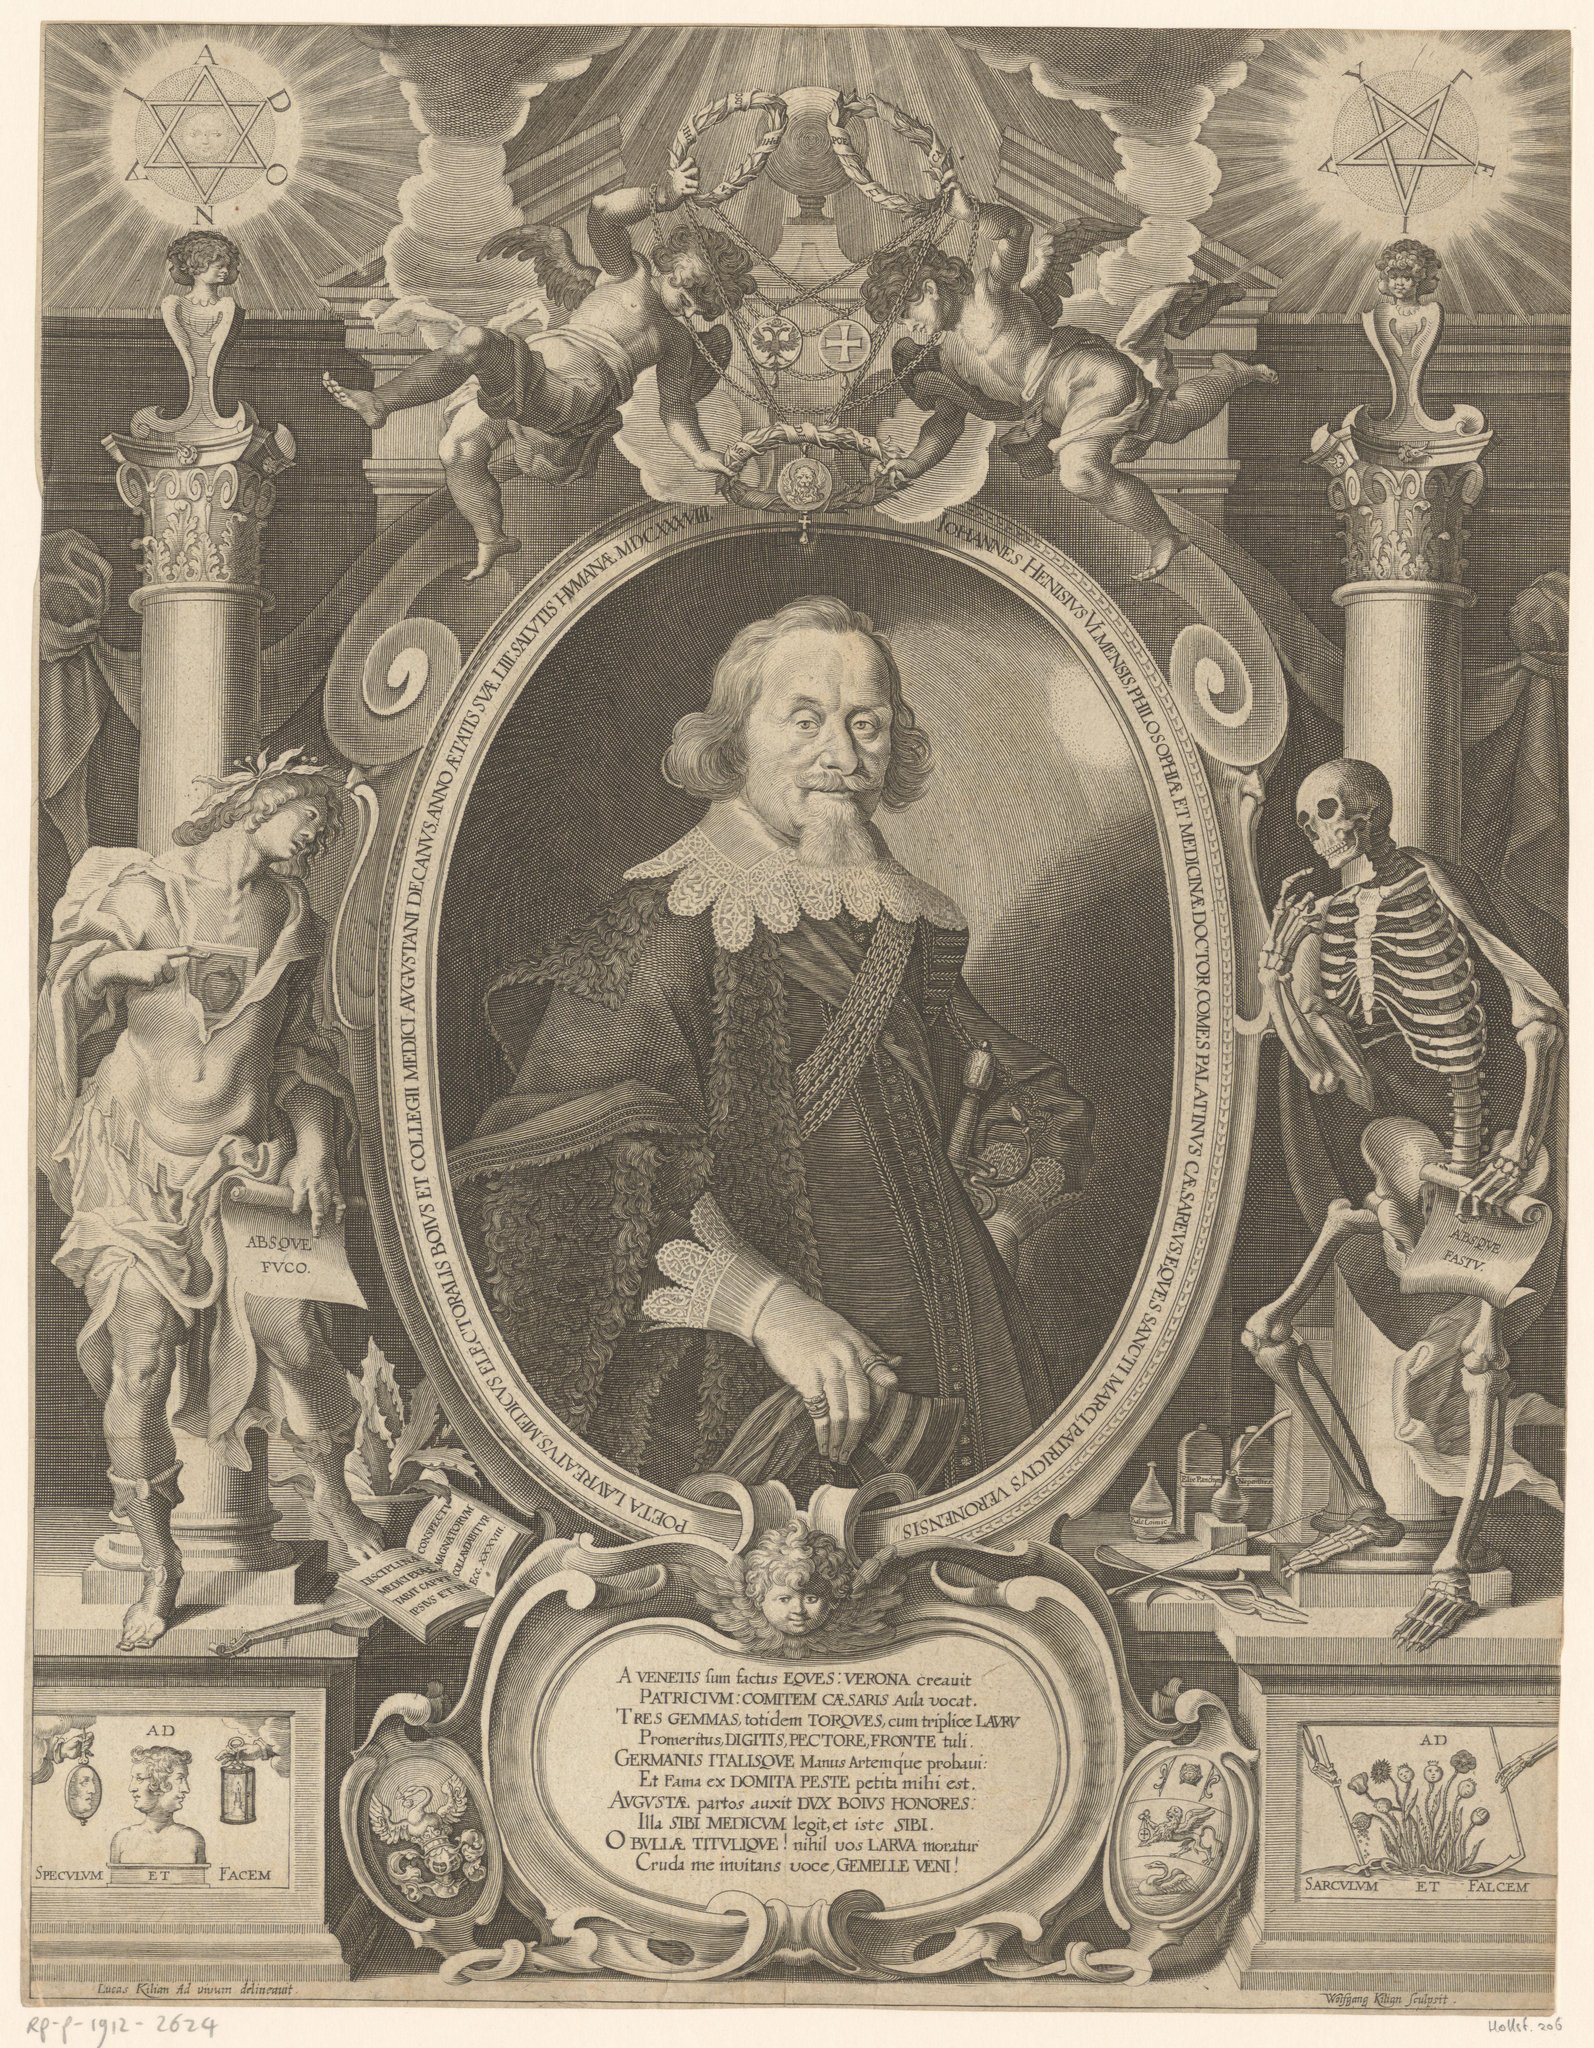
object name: print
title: Portret van Johannes Heins op 53-jarige leeftijd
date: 1638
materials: paper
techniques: engraving, etching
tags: symbol, emblem, sign ~ medicine, historical persons, 'vanitas' symbols, physician, doctor (+ portrait of scholar, scientist), pentagram (medical symbol)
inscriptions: collector's mark: Lugt 2228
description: Tekst in het Latijn in de omlijsting, in de cartouche en in de emblemen op de sokkels.